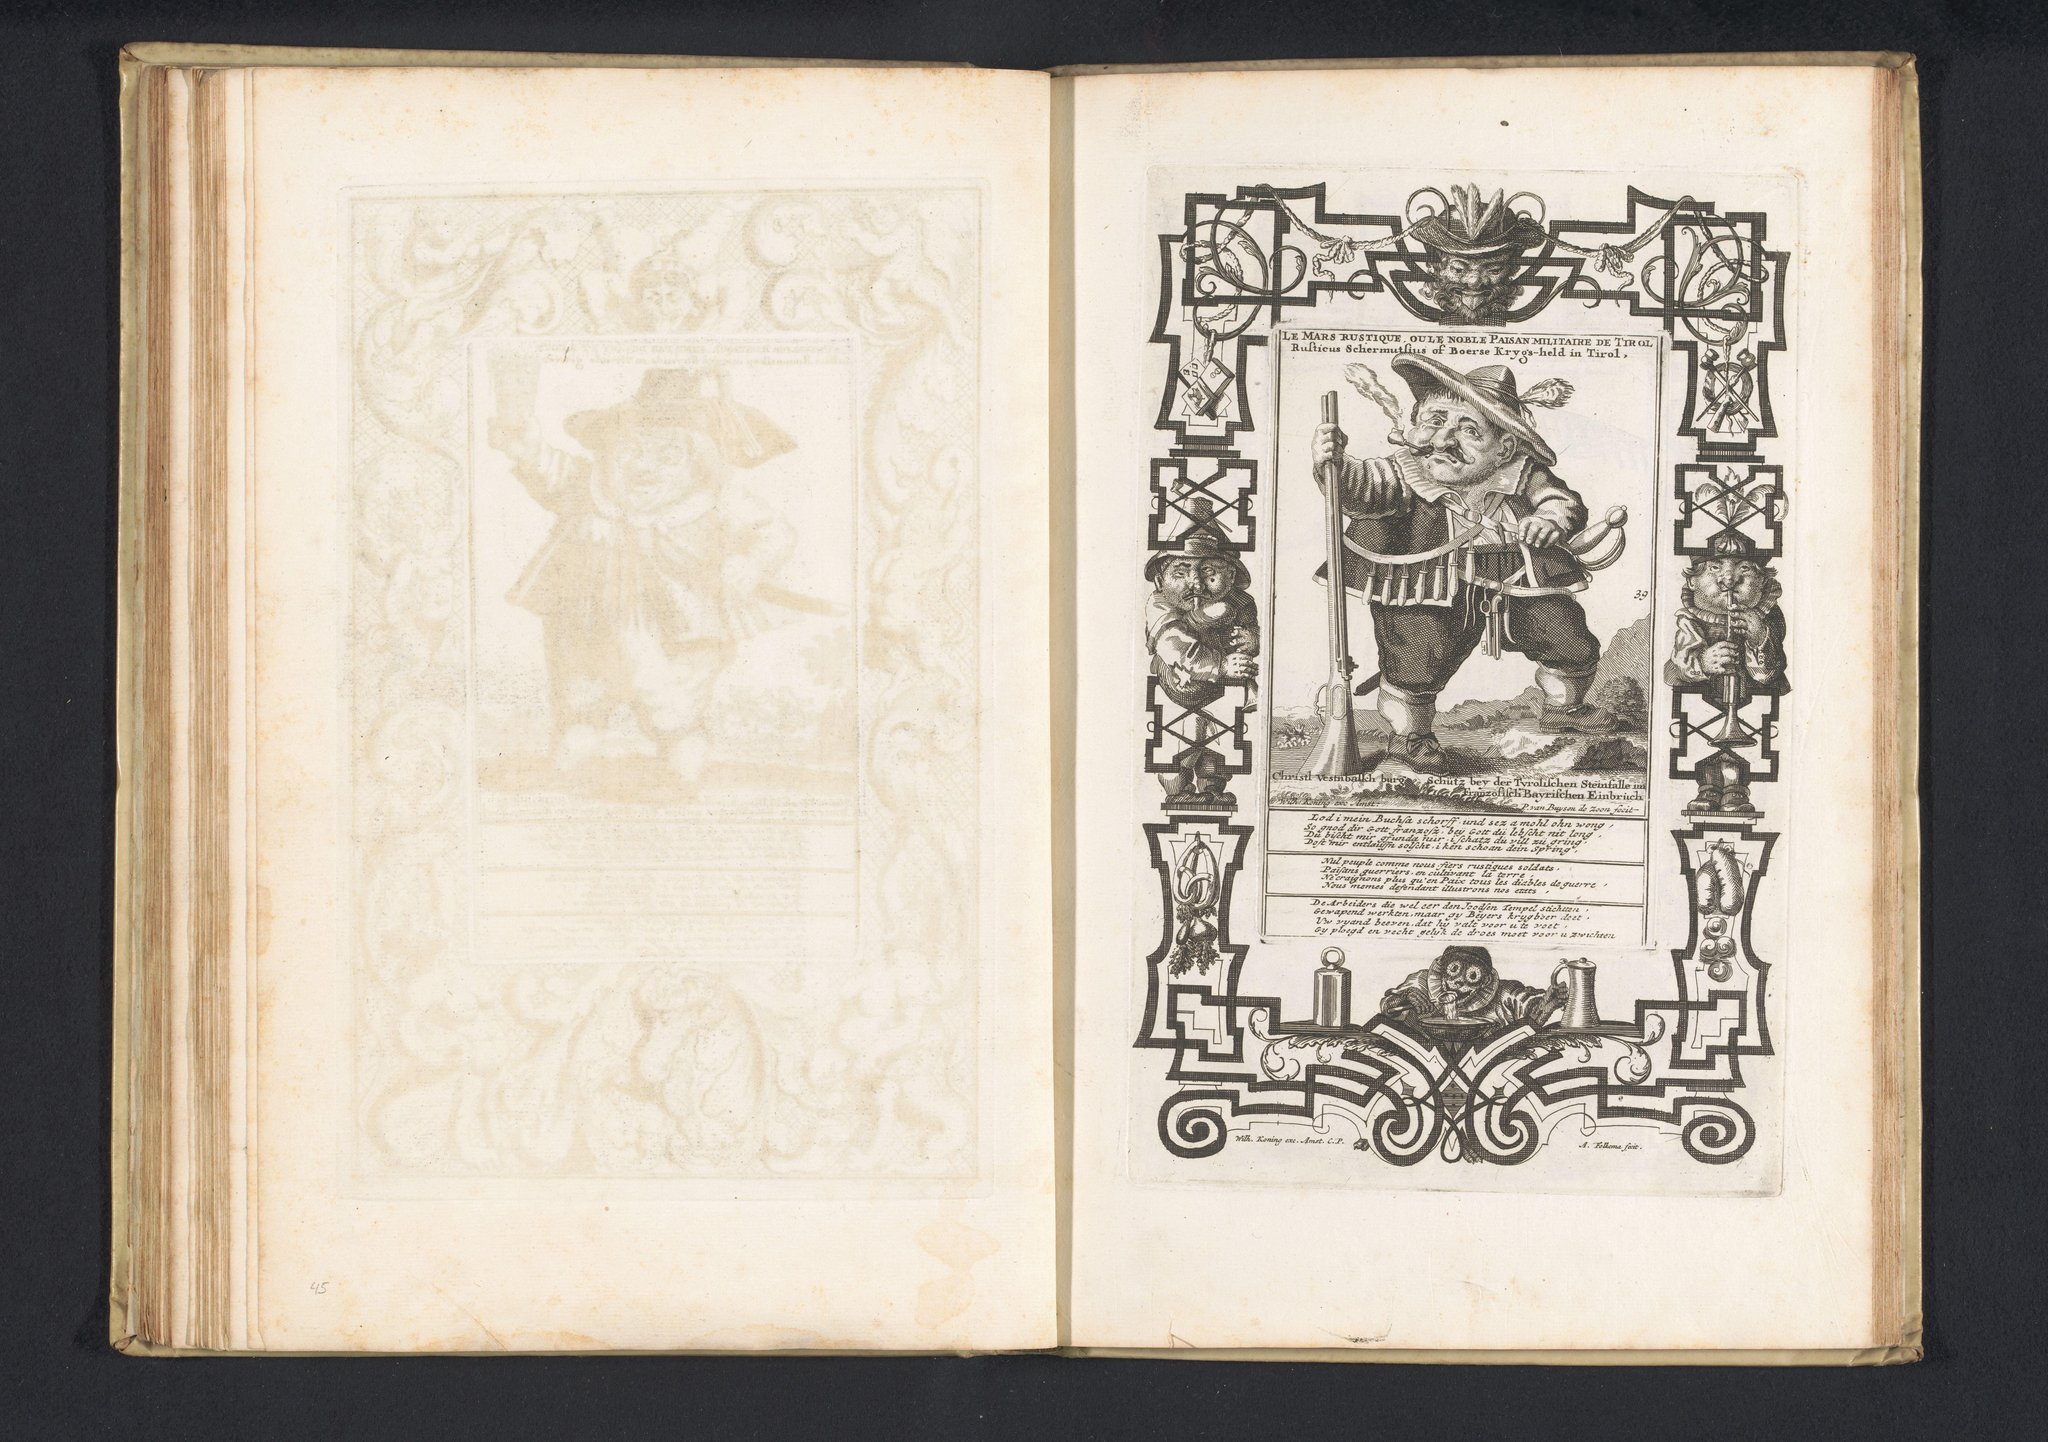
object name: caricature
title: De dwerg Rusticus Schermutsius, 1720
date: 1716-1720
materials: paper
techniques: etching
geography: northern netherlands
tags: caricatures (human types), little people, warfare; military affairs (+ citizen soldiery, civil guard, citizen militia)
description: De kleine mens Rusticus Schermutsius als lid van de Tiroolse schutterij. In het onderschrift verzen in het Duits, Frans en Nederlands. Genummerd rechts midden: 39. Afdruk binnen een decoratieve omlijsting gedrukt van een aparte plaat met muziek makende kleine mensen en onderaan een aap die pap eet. Onderdeel van deel II in de tweede Nederlandse gebonden uitgave uit 1720 (en gerelateerd aan de Windhandel in dat jaar) van een serie karikaturen van kleine mensen, bekend als Het Dwergentooneel, deels gekopieerd naar een ouder Duits voorbeeld.